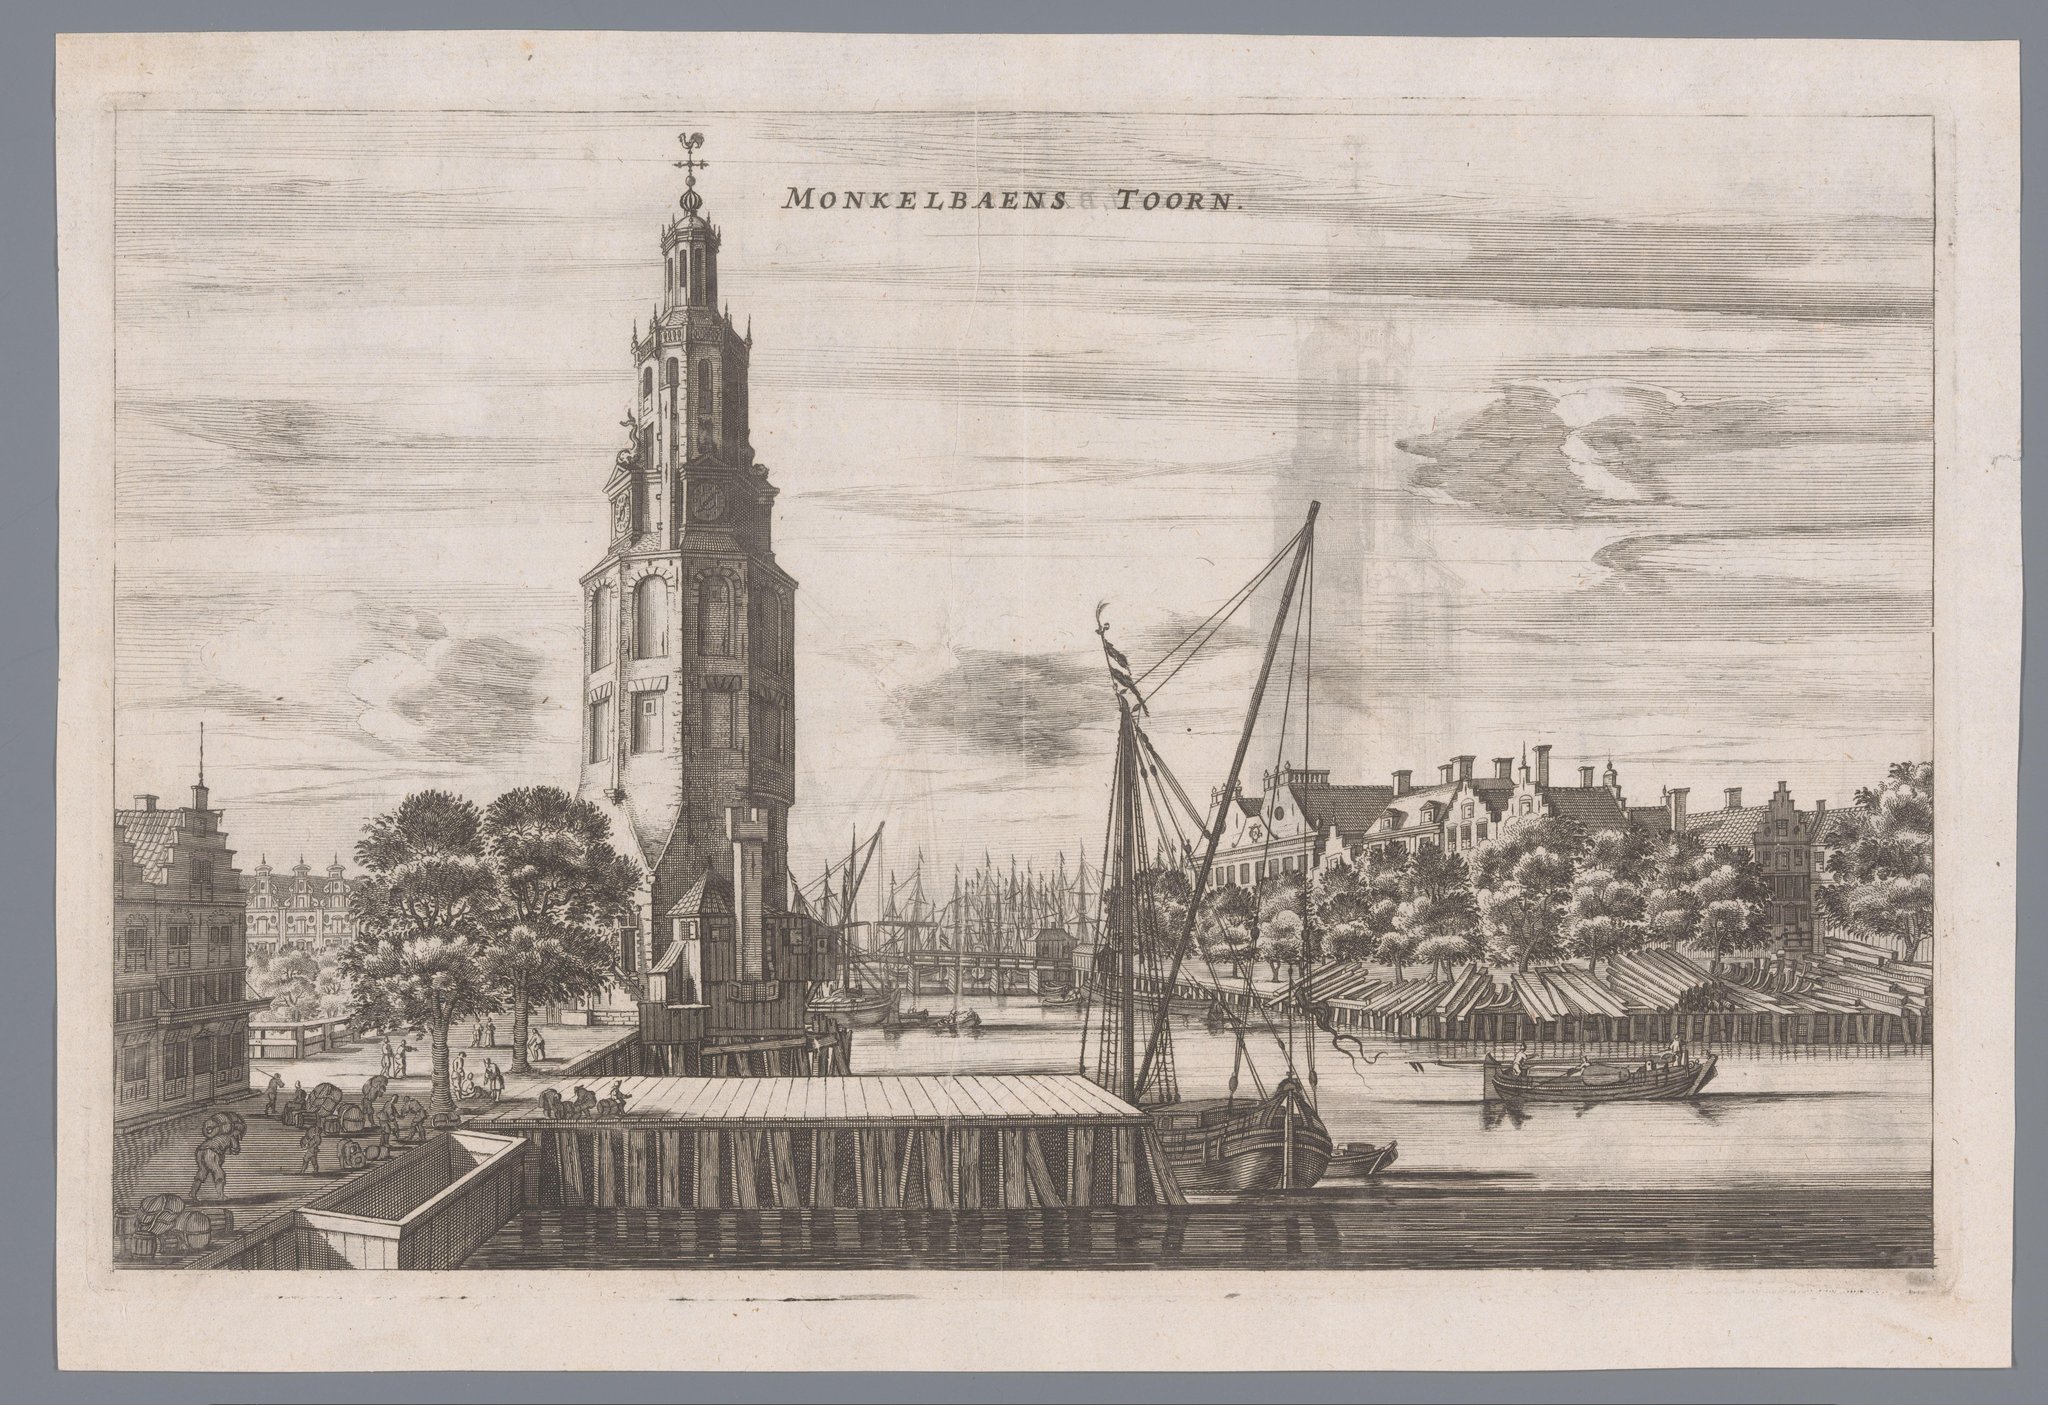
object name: book illustration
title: Gezicht op de Montelbaanstoren te Amsterdam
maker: jacob van meurs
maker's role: draughtsman, print maker, publisher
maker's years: 1619-1680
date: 1663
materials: paper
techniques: engraving, etching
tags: urban housing, sailing-ship, sailing-boat, towers ~ fortified city, rowing-boat, canoe, etc., bridge in city across river, canal, etc.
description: Deze prent komt voor in: Dapper, Olfert. Historische beschryving der stadt Amsterdam (...). Amsterdam: Jacob van Meurs, 1663, p. 402-403. En in: Zesen, Philipp von. Beschreibung der Stadt Amsterdam (...). Amsterdam: Joachim Nosche, 1664, p. 150-151. In sommige exemplaren van Olfert Dapper komt een iets gewijzigde staat voor, met een Franse titel boven het Nederlandse opschrift.